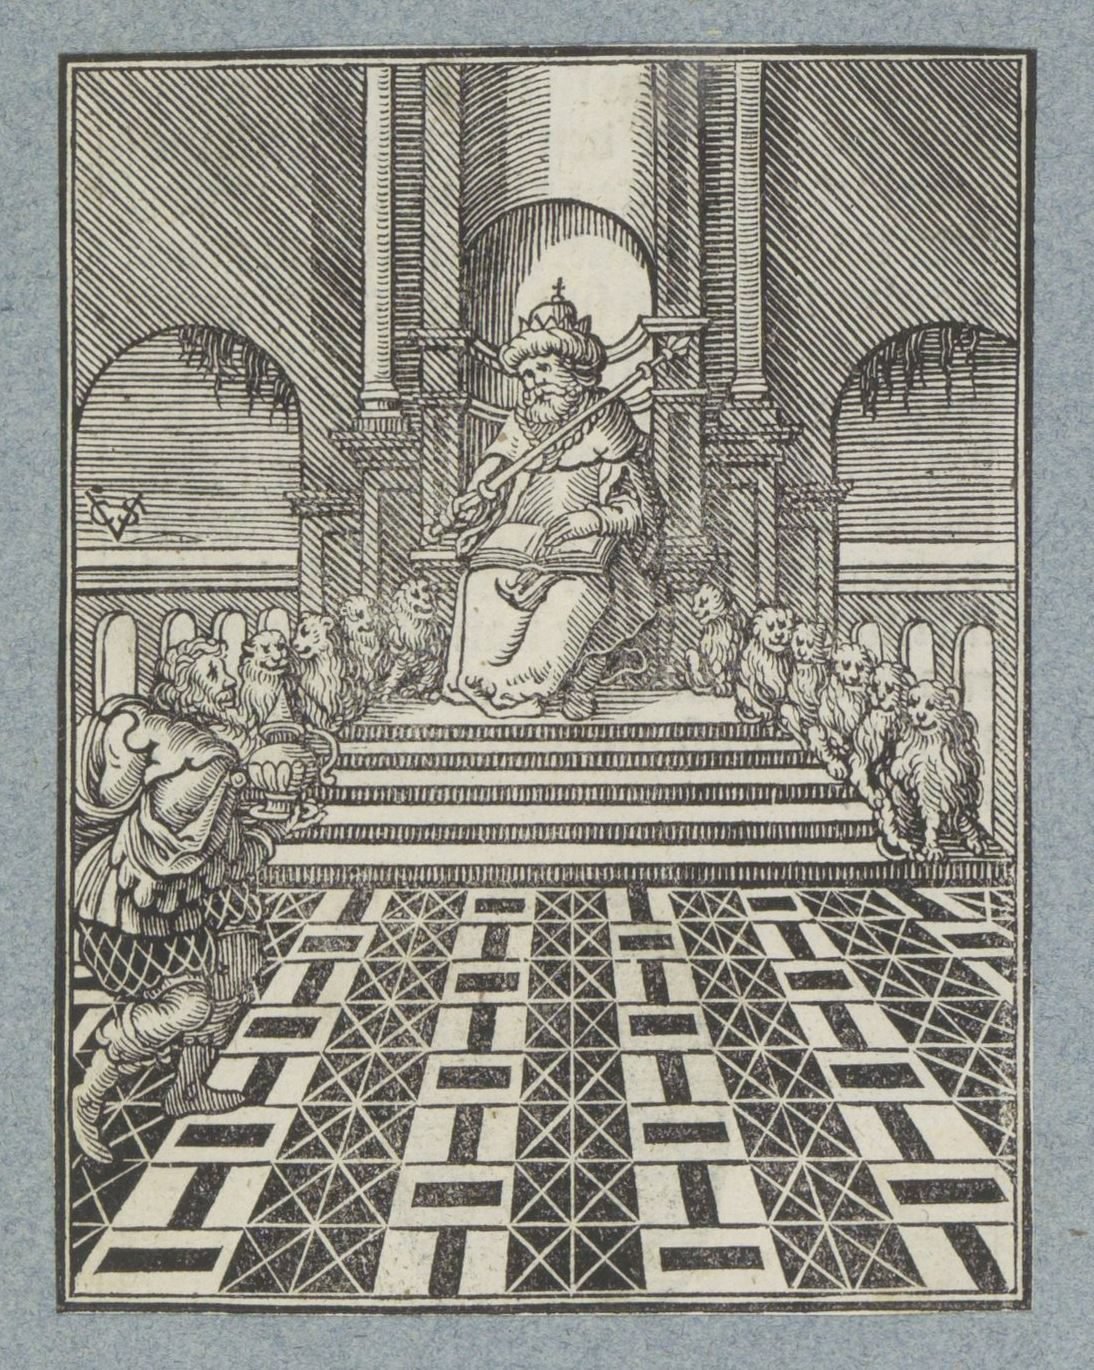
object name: print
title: Salomo's troon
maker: pieter jacobsz. paets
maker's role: publisher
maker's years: 1587-1667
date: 1645-1646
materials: paper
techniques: letterpress printing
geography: amsterdam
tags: solomon and his court, story of solomon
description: Koning Salomo zit op zijn troon. Hij heeft een scepter in zijn hand en op zijn schoot ligt een boek. Volgens 1 koningen 10 was de troon van ivoor, overtrokken met zuiver goud. Zes treden leidden naar de troon, die aan de bovenkant een ronde hoofdsteun had en armleuningen aan weerskanten van de zitting. Naast de armleuningen stonden twee leeuwen en op de zes treden stonden twaalf leeuwen, één aan elke kant van iedere tree. De man links biedt een geschenk aan. De prent maakt deel uit van een album.